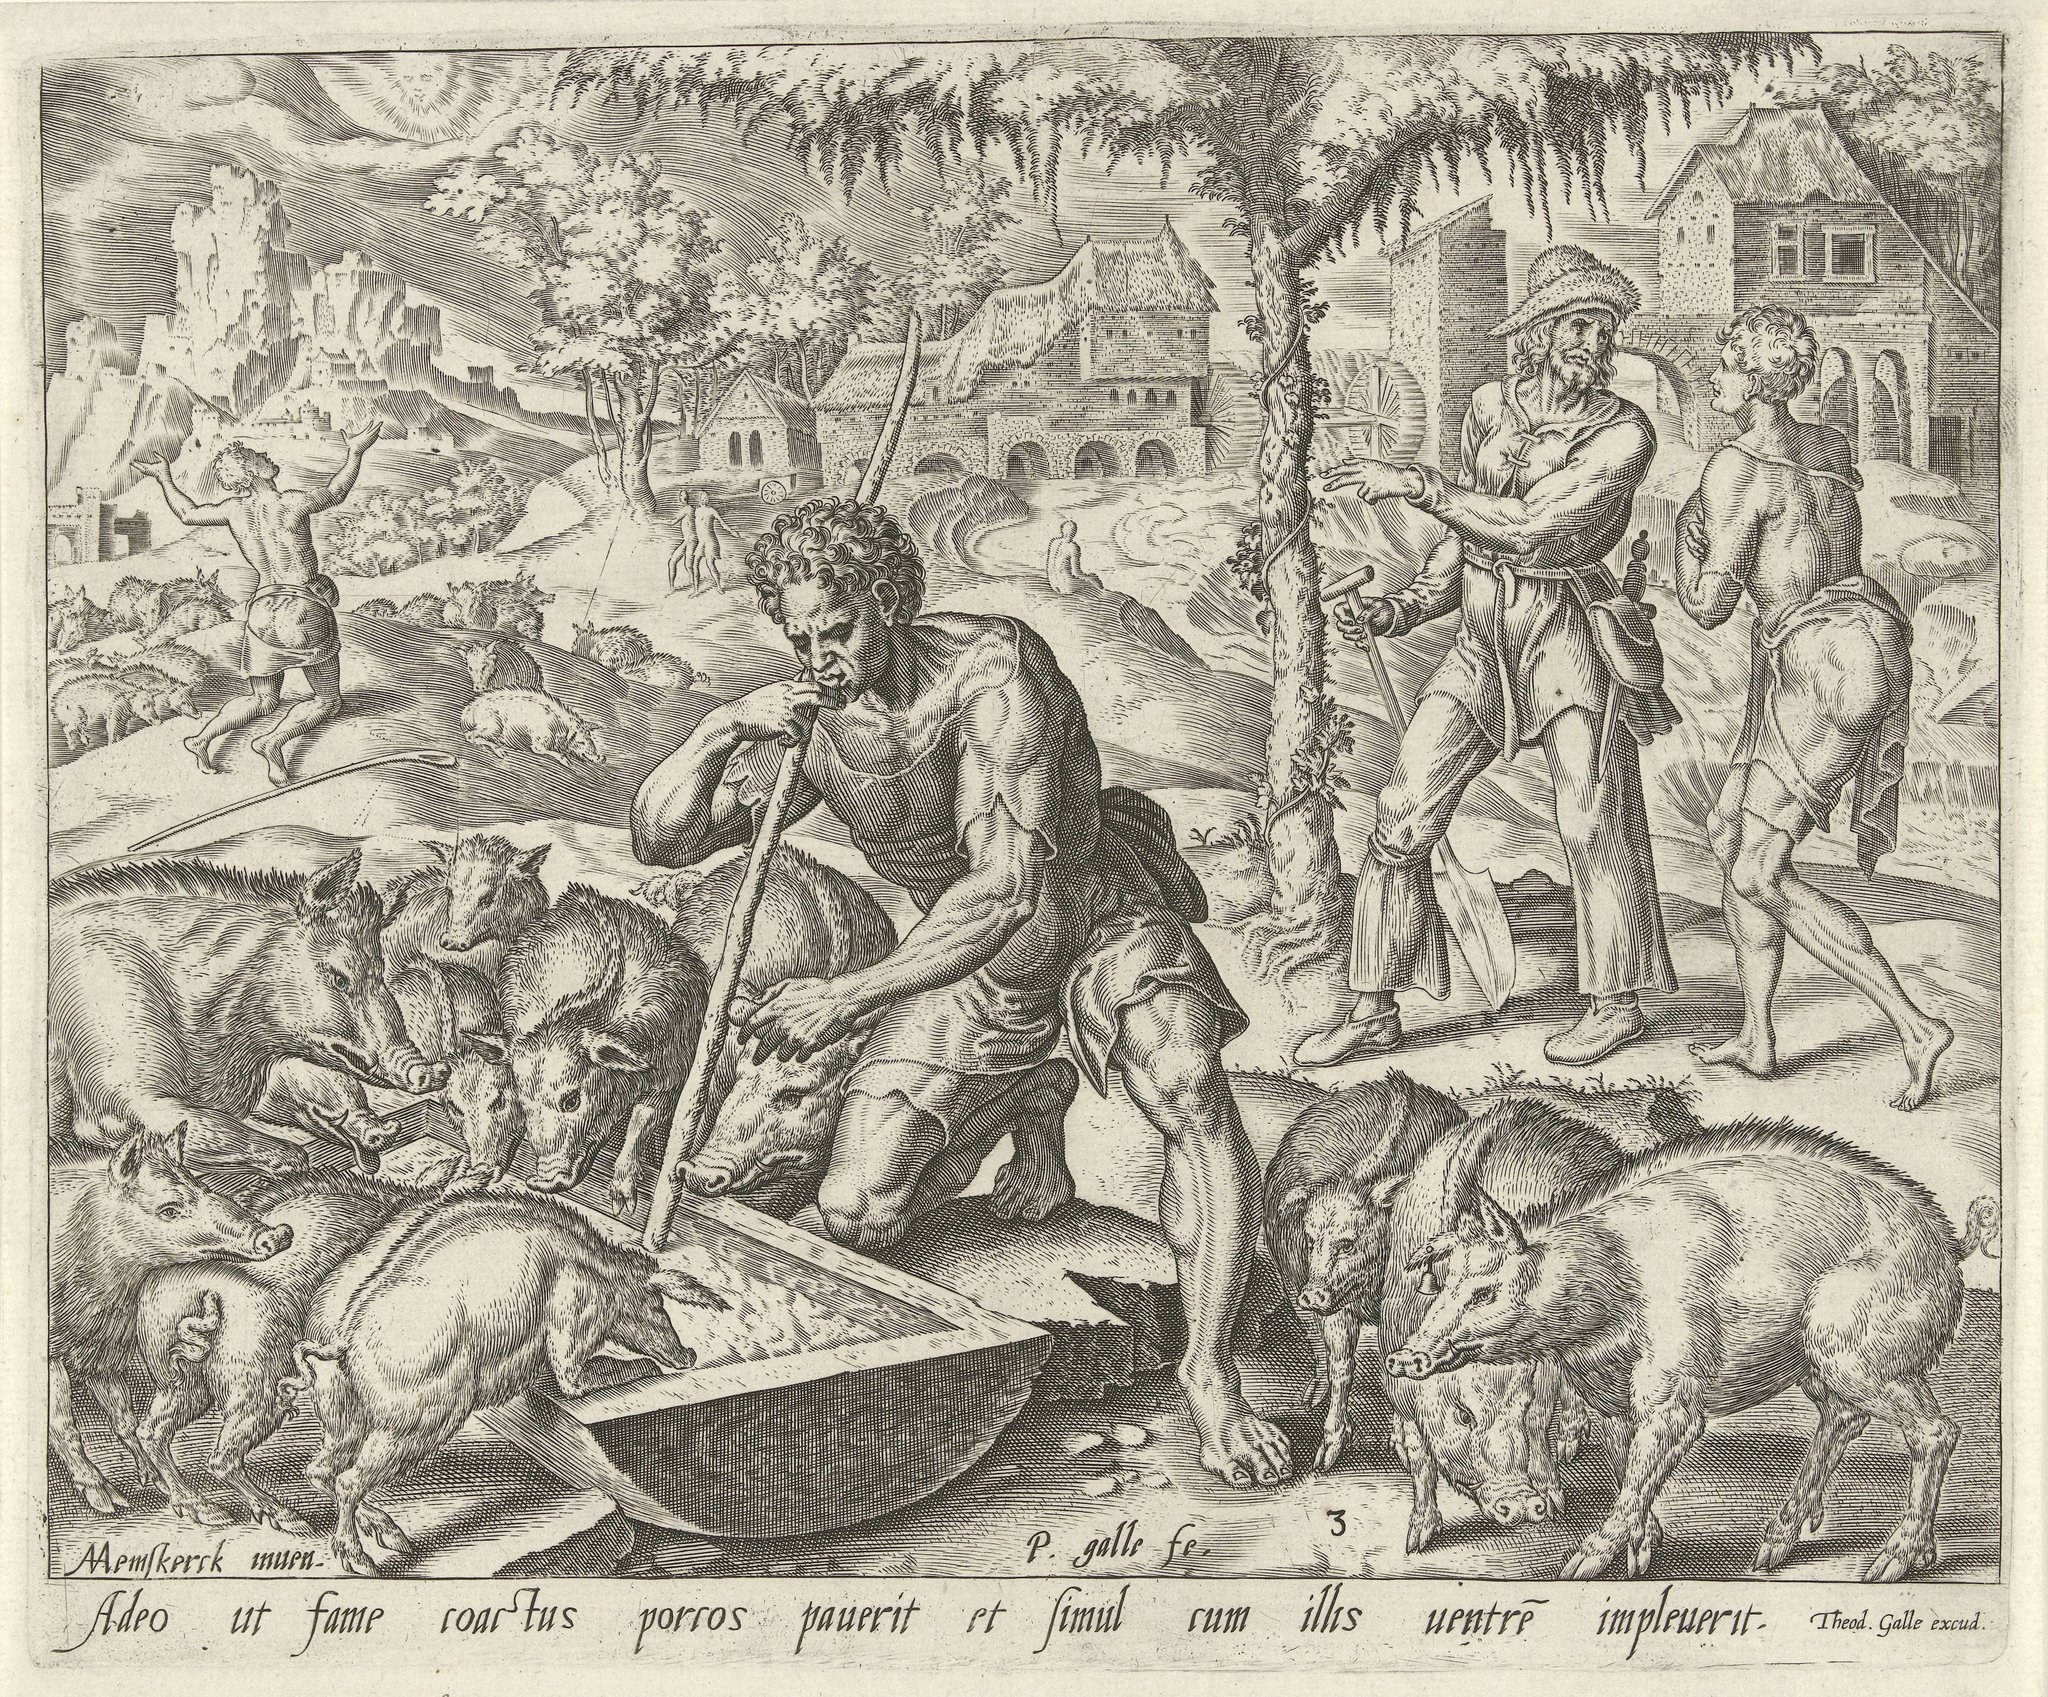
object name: print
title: Gelijkenis van de verloren zoon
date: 1596-1633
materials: paper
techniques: engraving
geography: haarlem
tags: the prodigal son repents his former life and prays, the parable of the prodigal son (luke 15:11-32), the prodigal son tends the swine and eats from their trough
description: De verloren zoon heeft zijn erfenis verkwist en werkt bij een boer als varkenshoeder. Hij knielt tussen de varkens en eet met hun samen uit de voederbak. Linksachter is hij biddend te zien.